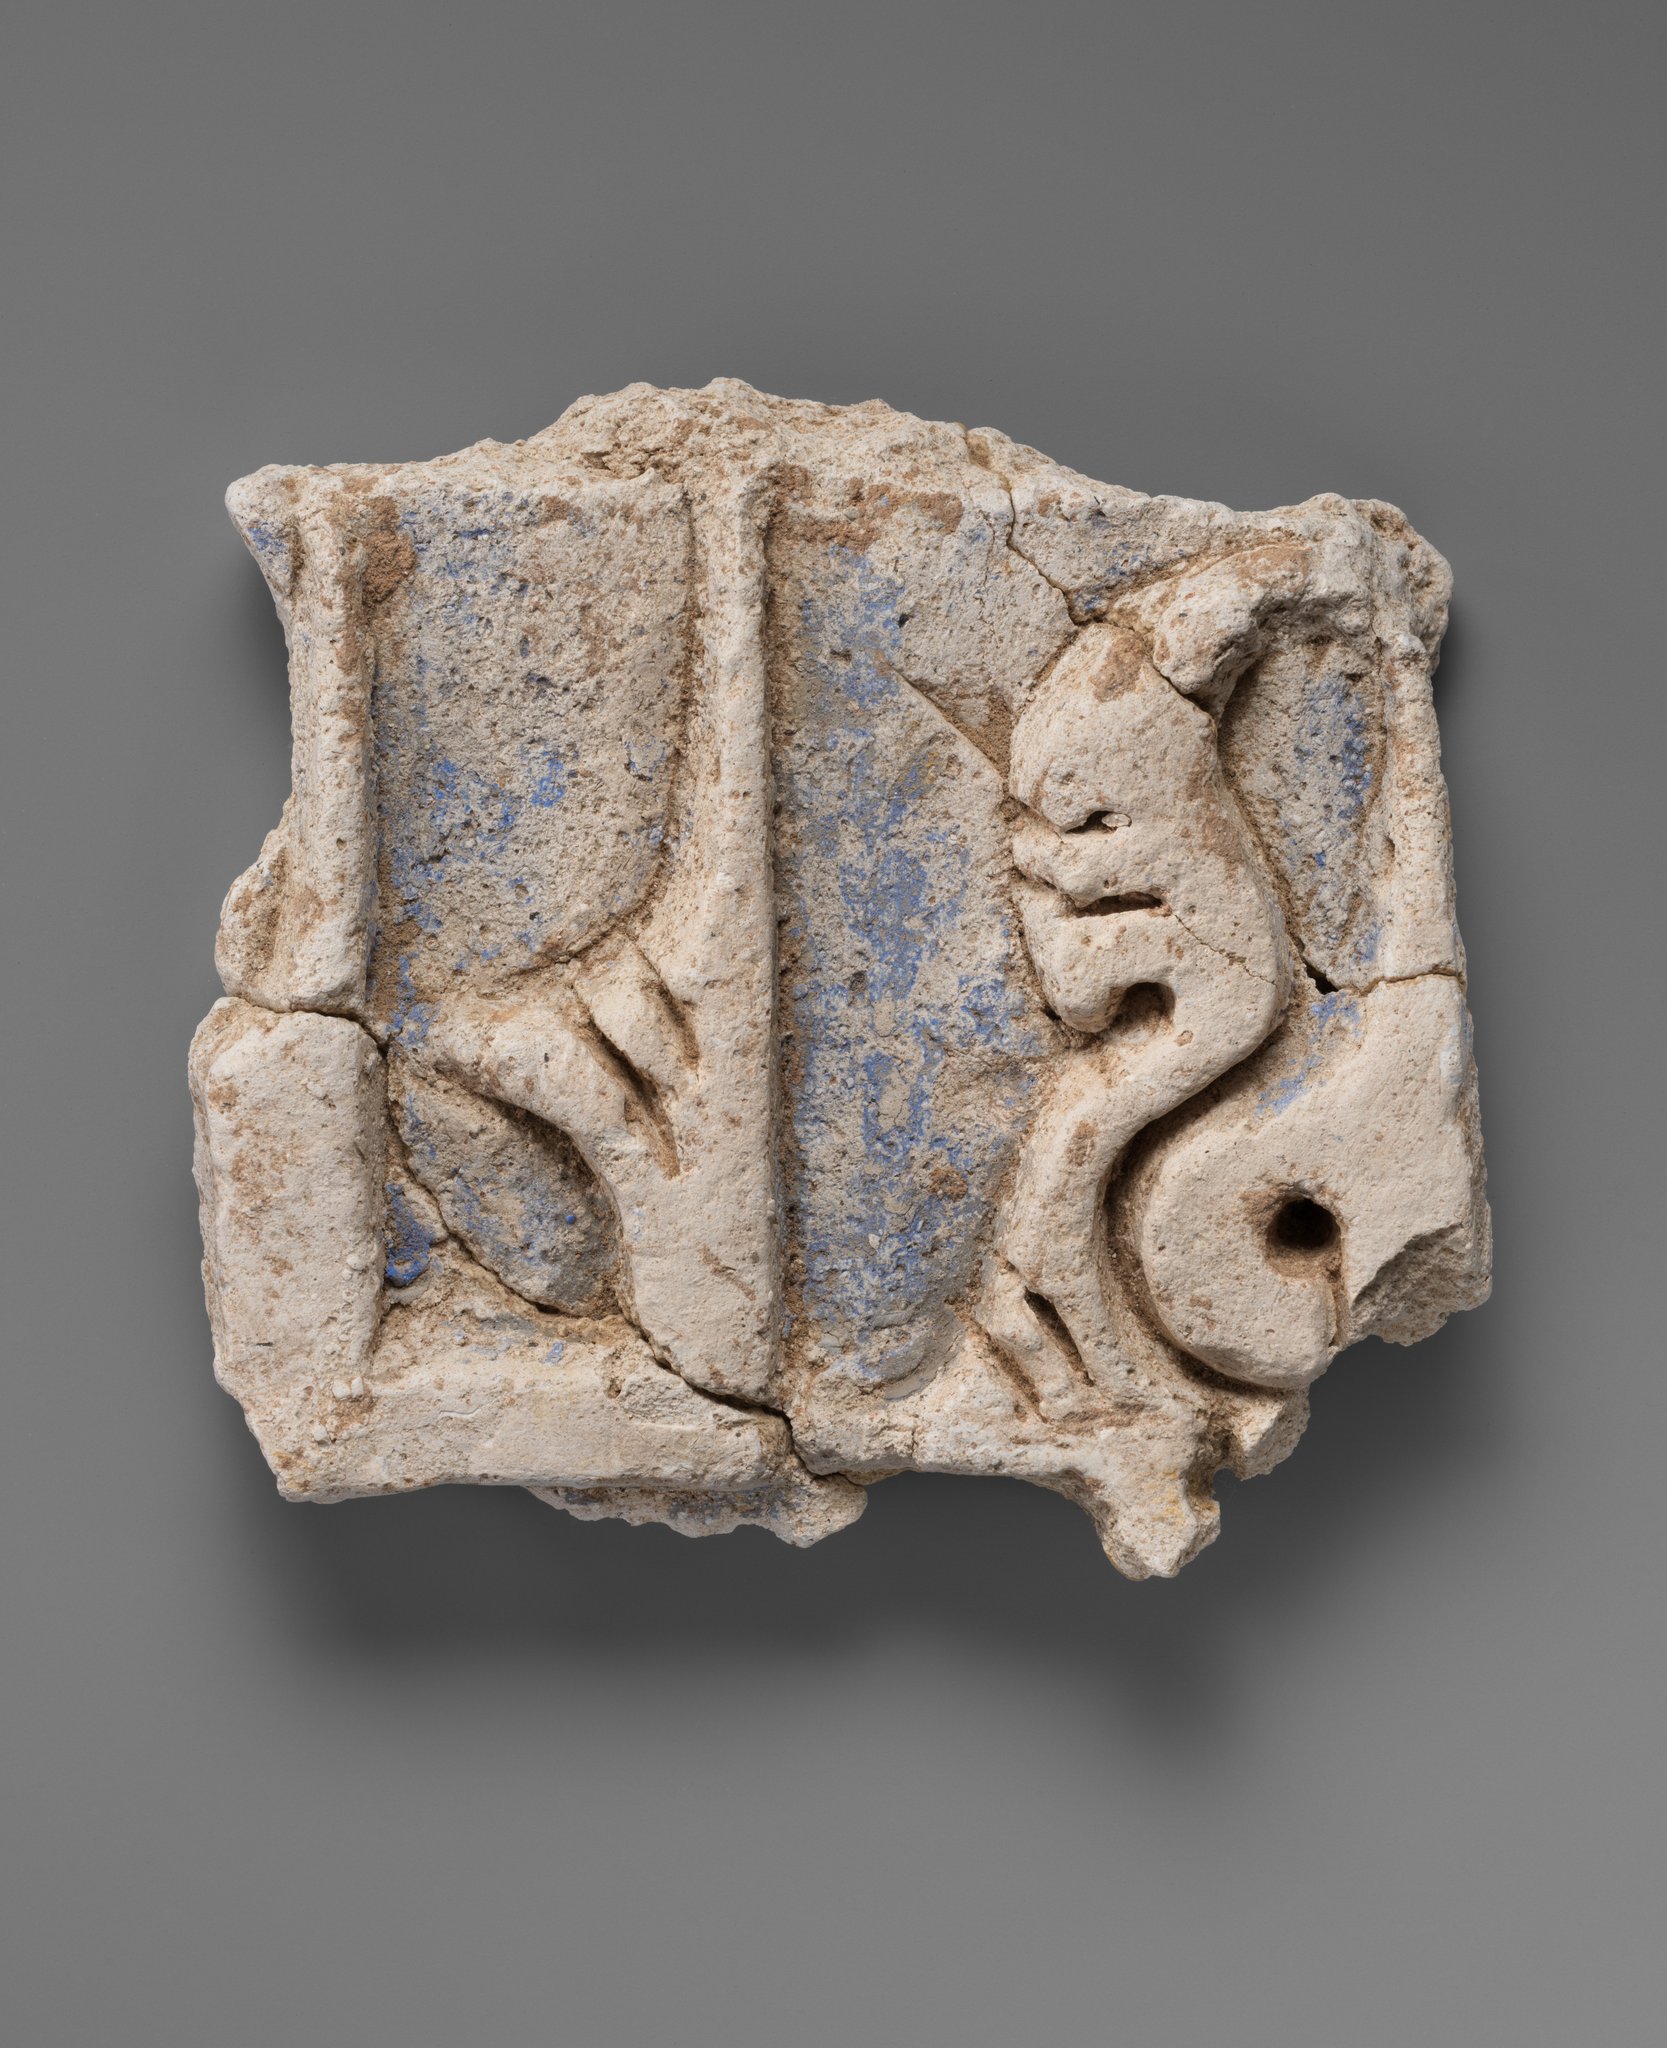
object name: fragment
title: Stucco Fragment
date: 701-1200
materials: plaster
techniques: carving, painting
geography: iran